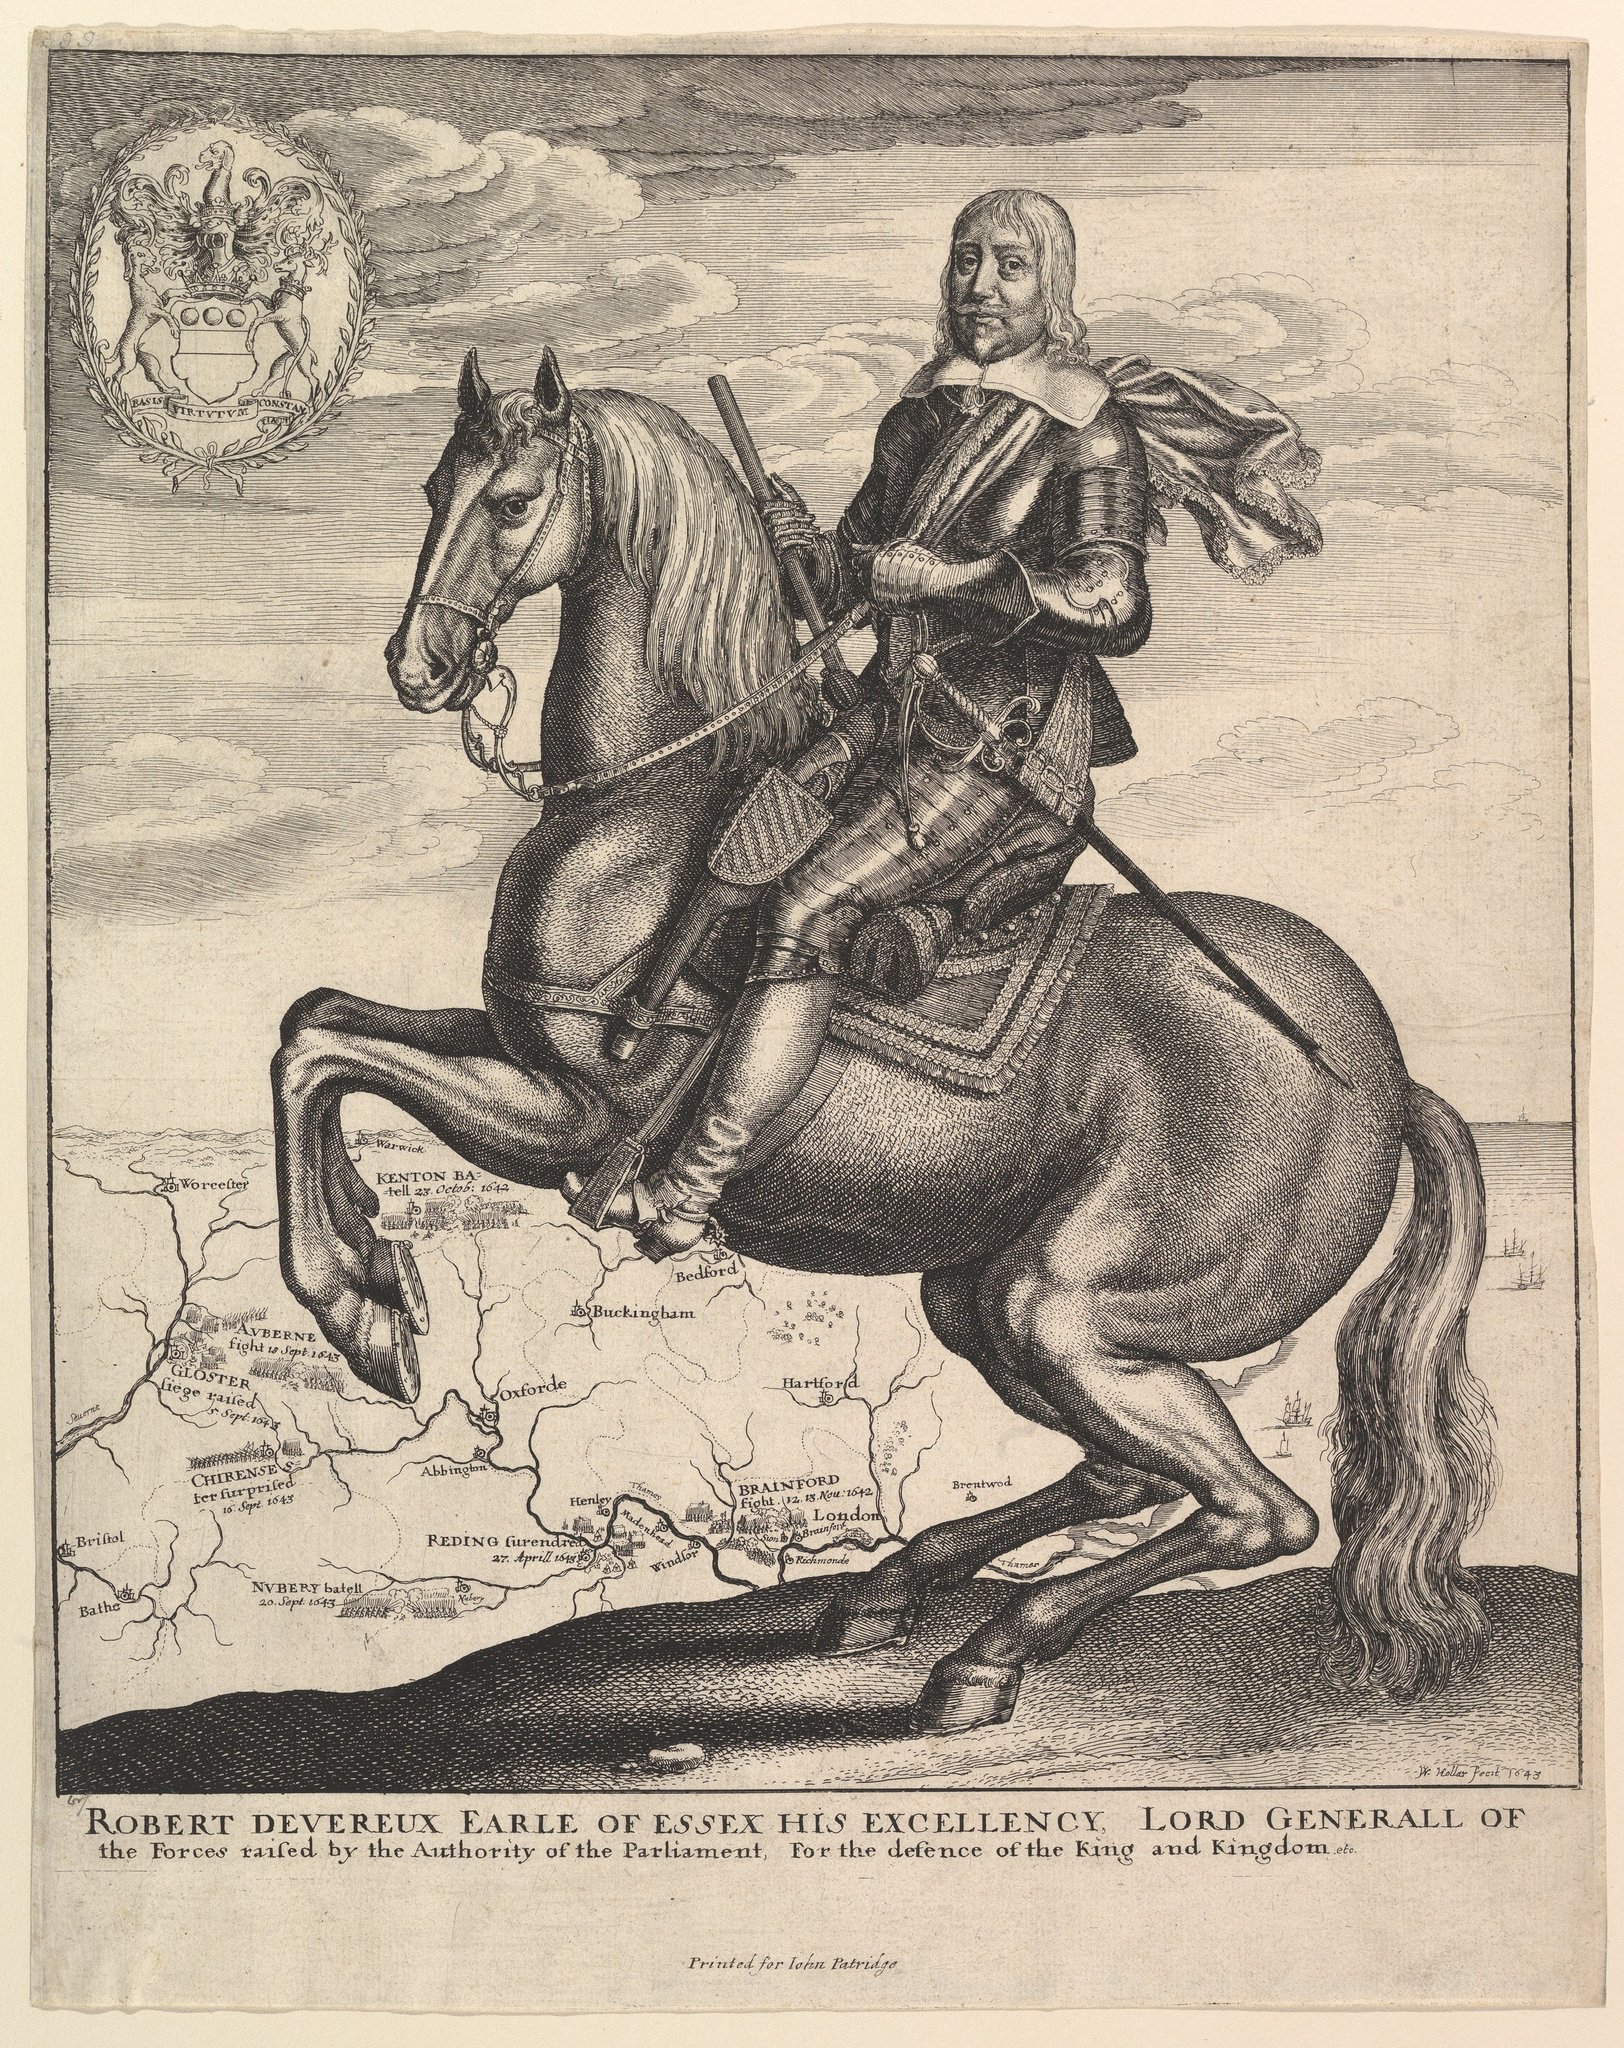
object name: print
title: Earl of Essex on Horseback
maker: wenceslaus hollar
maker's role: artist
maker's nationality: bohemian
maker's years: 1607-1677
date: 1643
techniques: etching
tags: men,horses,coat of arms,maps